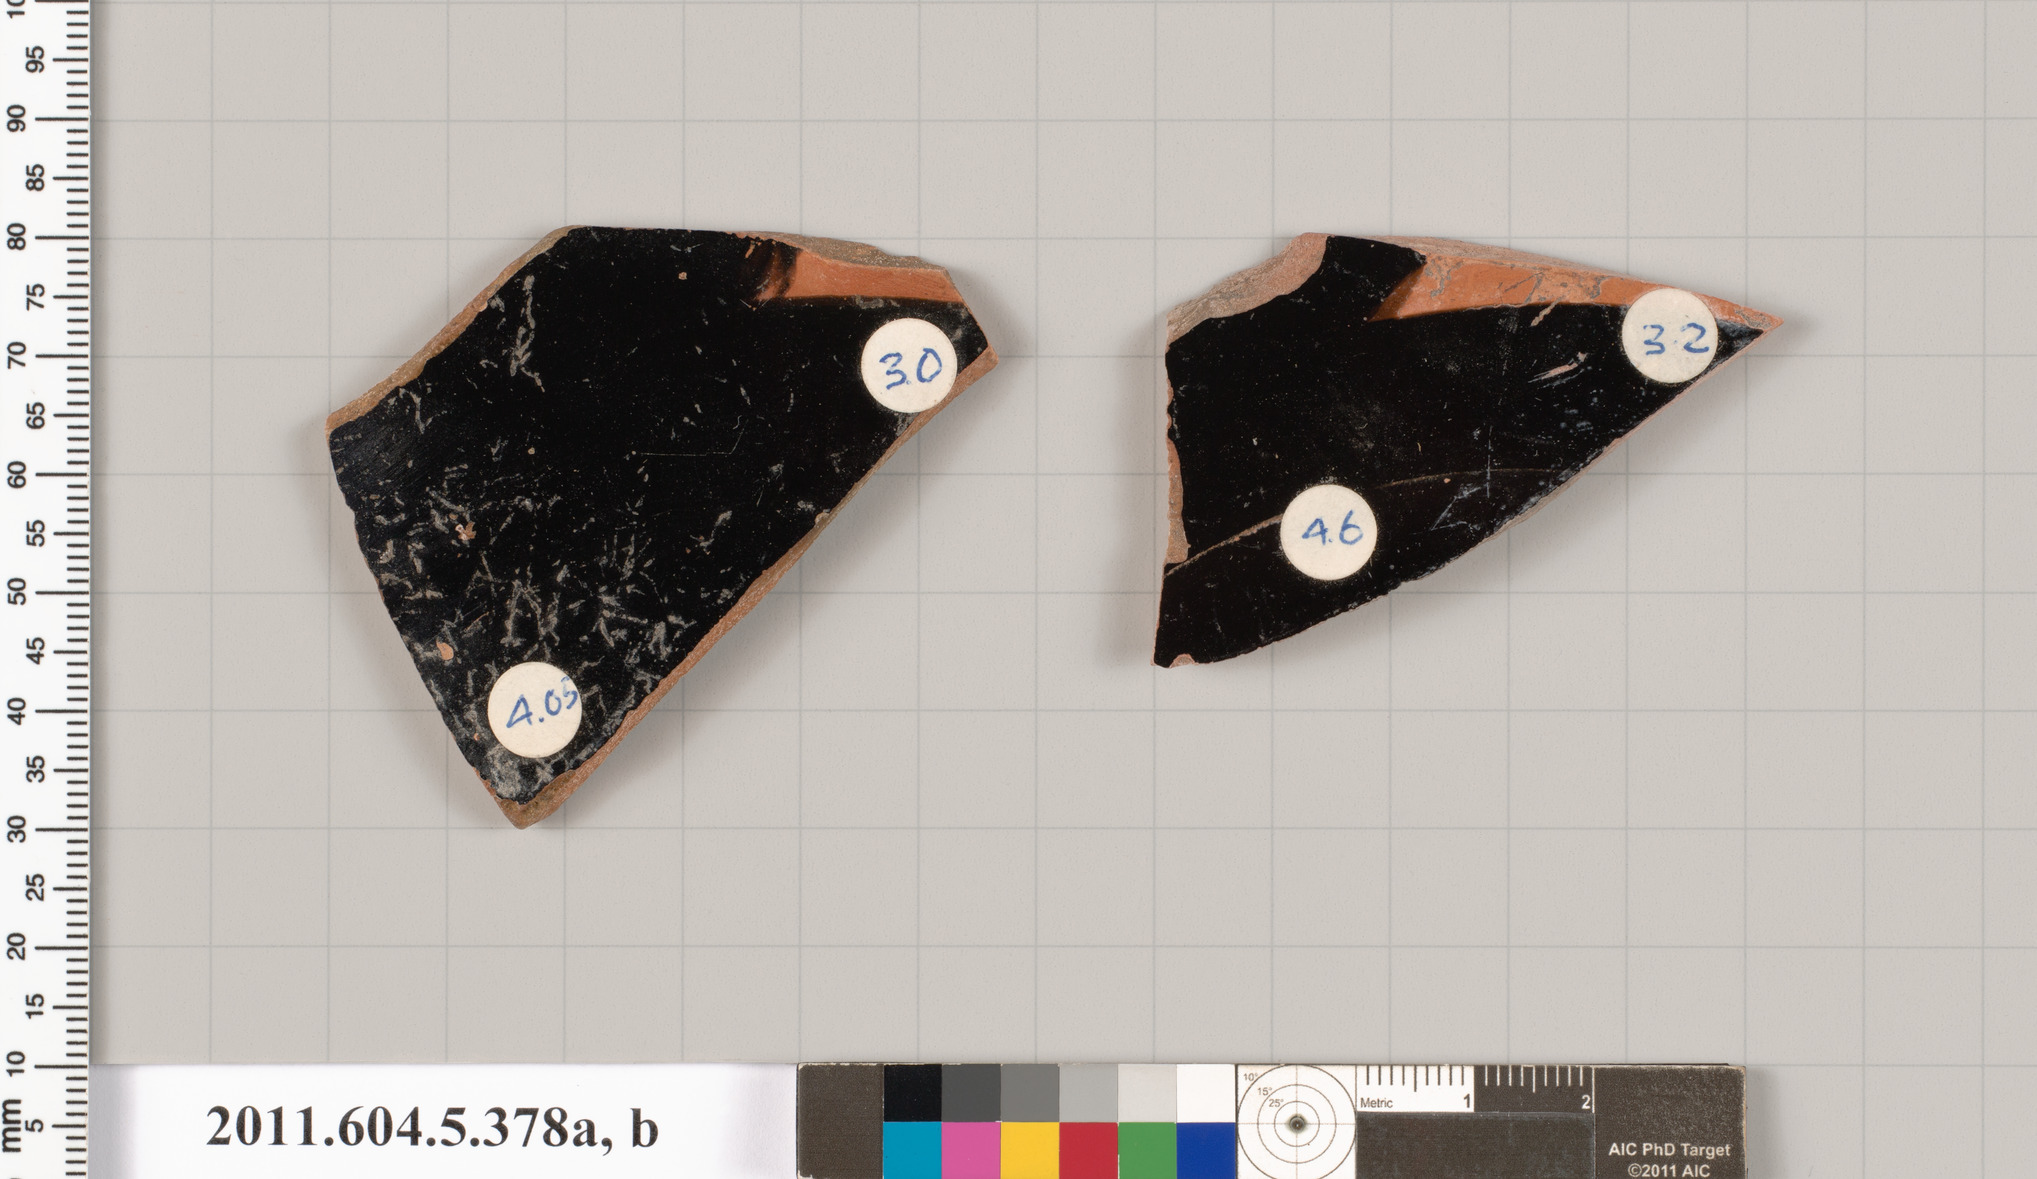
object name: kylix fragment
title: Terracotta fragments of kylikes (drinking cups)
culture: greek, attic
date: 600-401 BCE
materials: terracotta